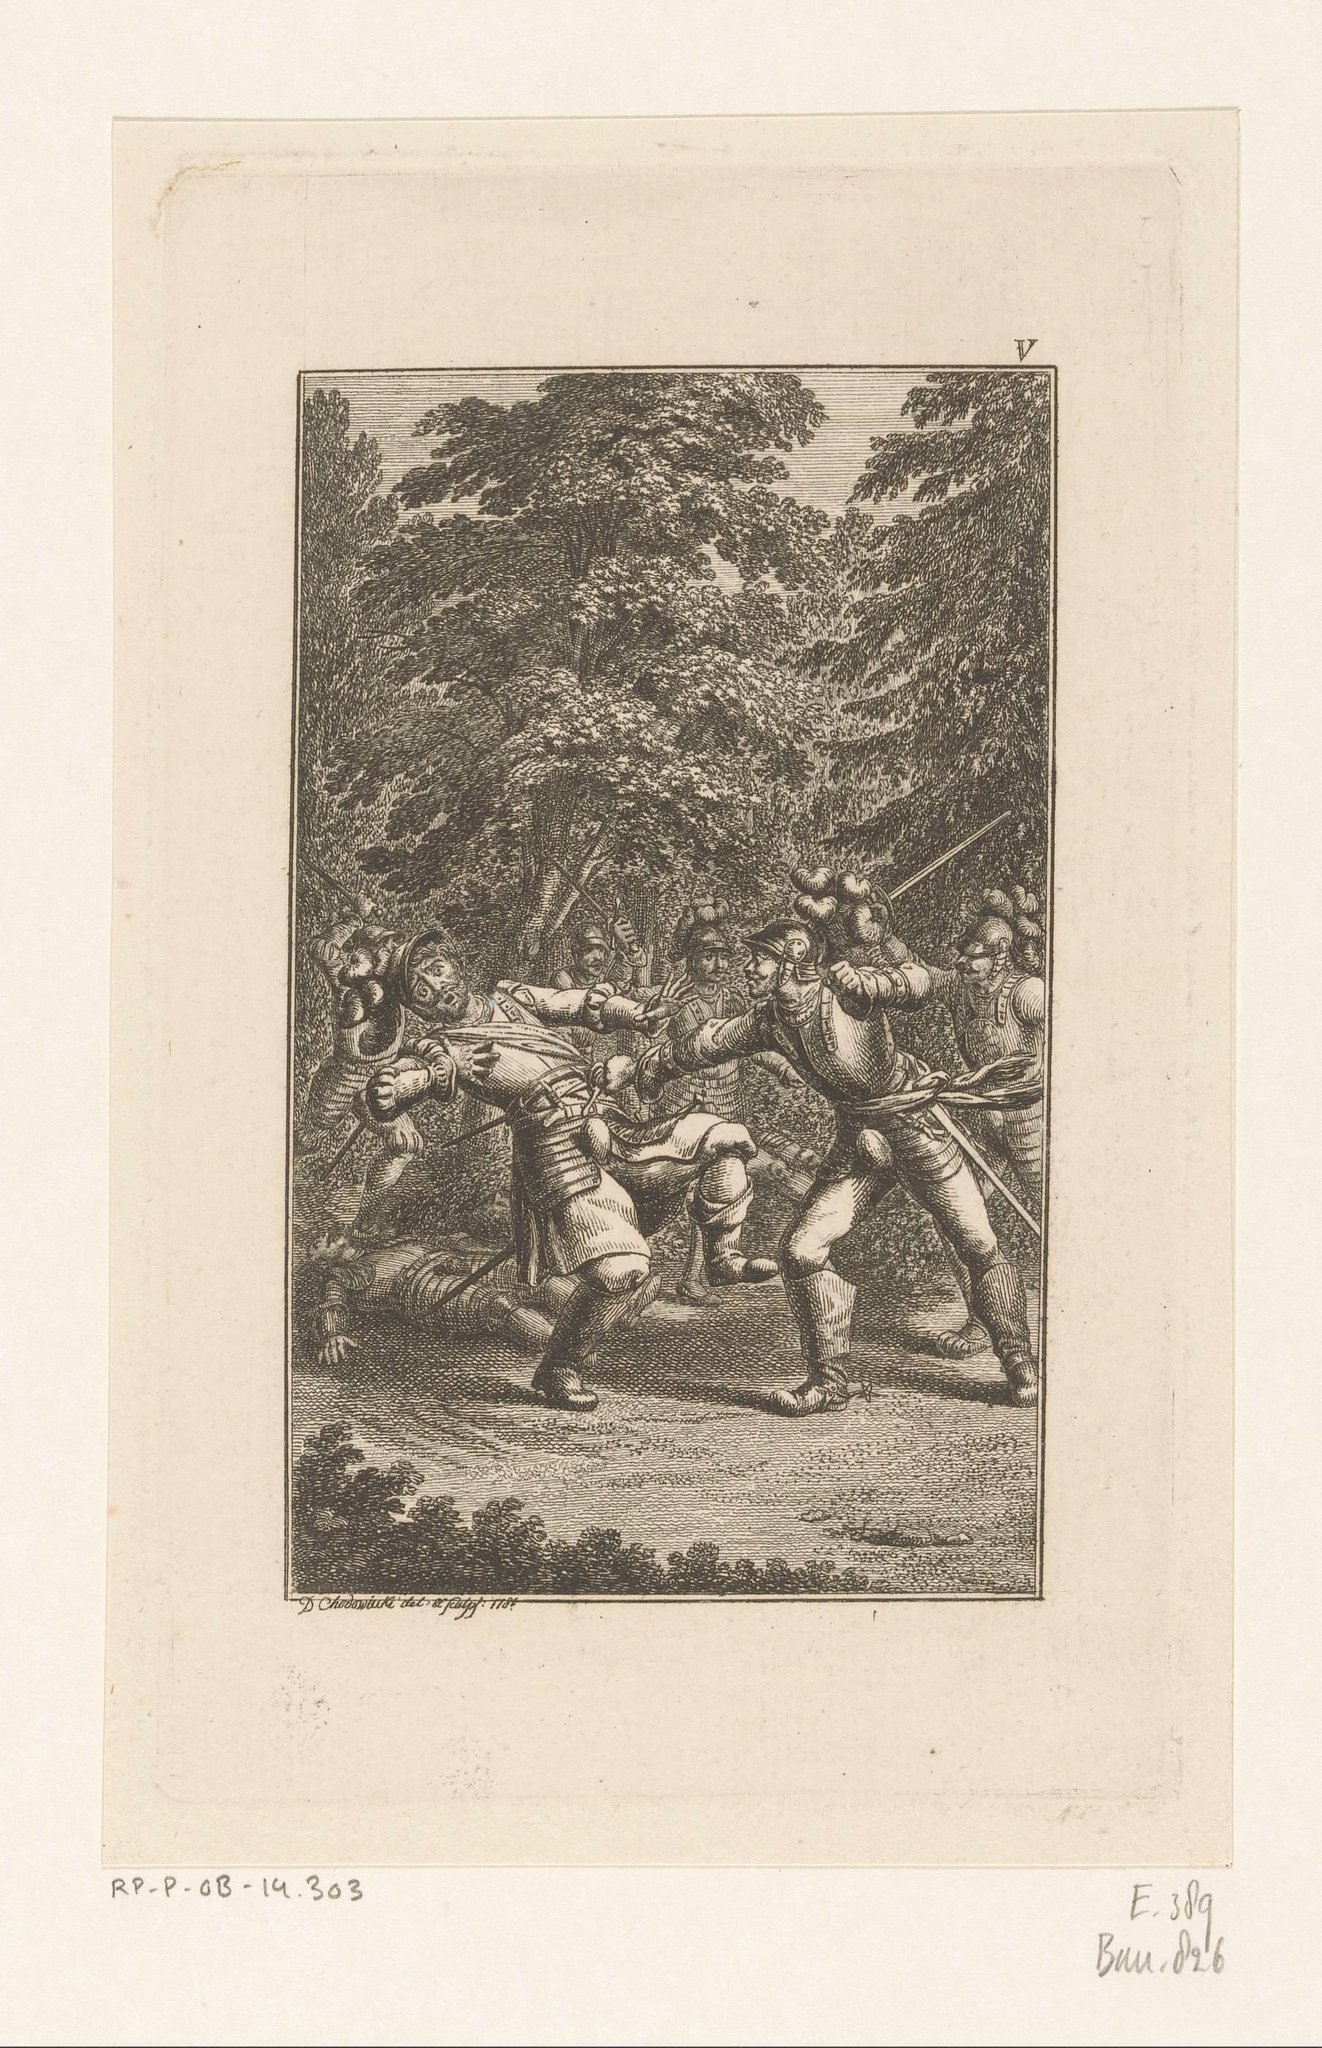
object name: print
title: Rolf wordt dodelijk verwond door Hiartwar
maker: daniel nikolaus chodowiecki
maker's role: draughtsman, print maker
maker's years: 1726-1801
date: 1781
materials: paper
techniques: etching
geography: berlin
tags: copenhagen (city), violent death by sword, armour, forest, wood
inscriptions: collector's mark: Lugt 2228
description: Prent gebruikt voor: Ewald, Johannes. Johannes Ewald's samtlige Skrifter. 4 dln. Kopenhagen: Christian Gotlob Proft, 1781-1791.